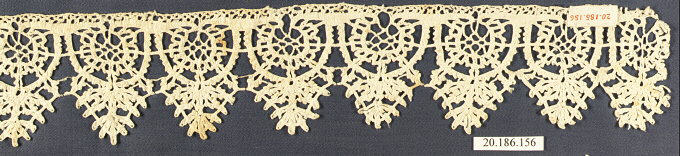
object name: edging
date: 1601-1700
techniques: lace